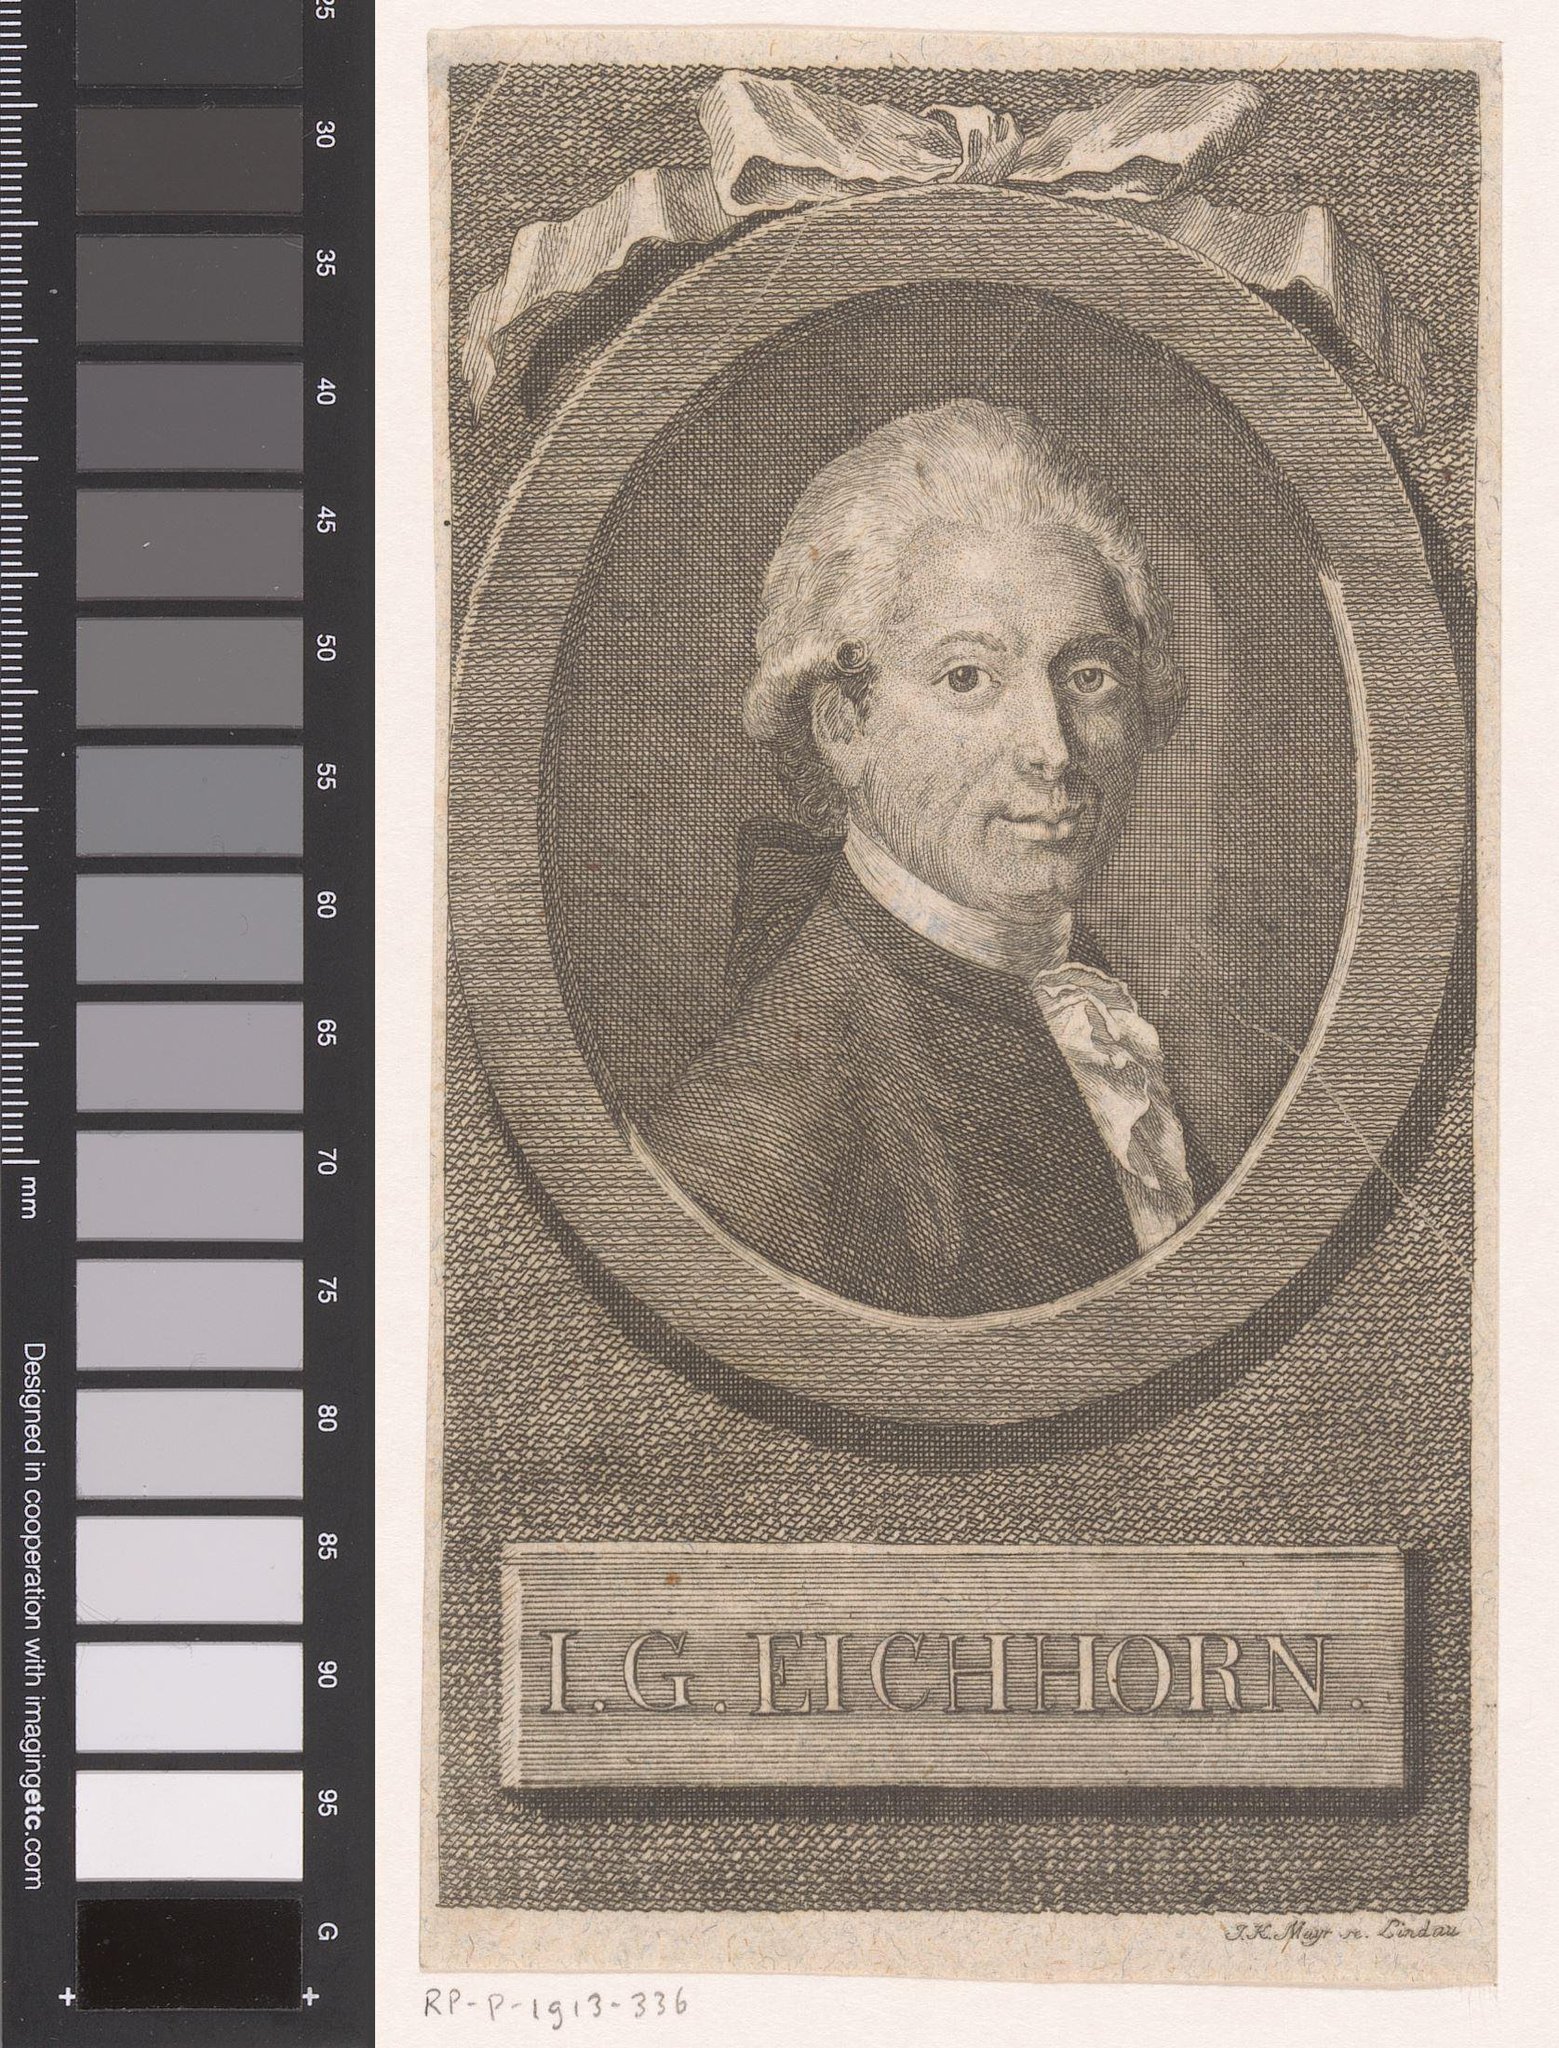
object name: print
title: Portret van Johann Gottfried Eichhorn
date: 1760-1839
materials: paper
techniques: engraving, etching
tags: historical persons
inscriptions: collector's mark: Lugt 2228